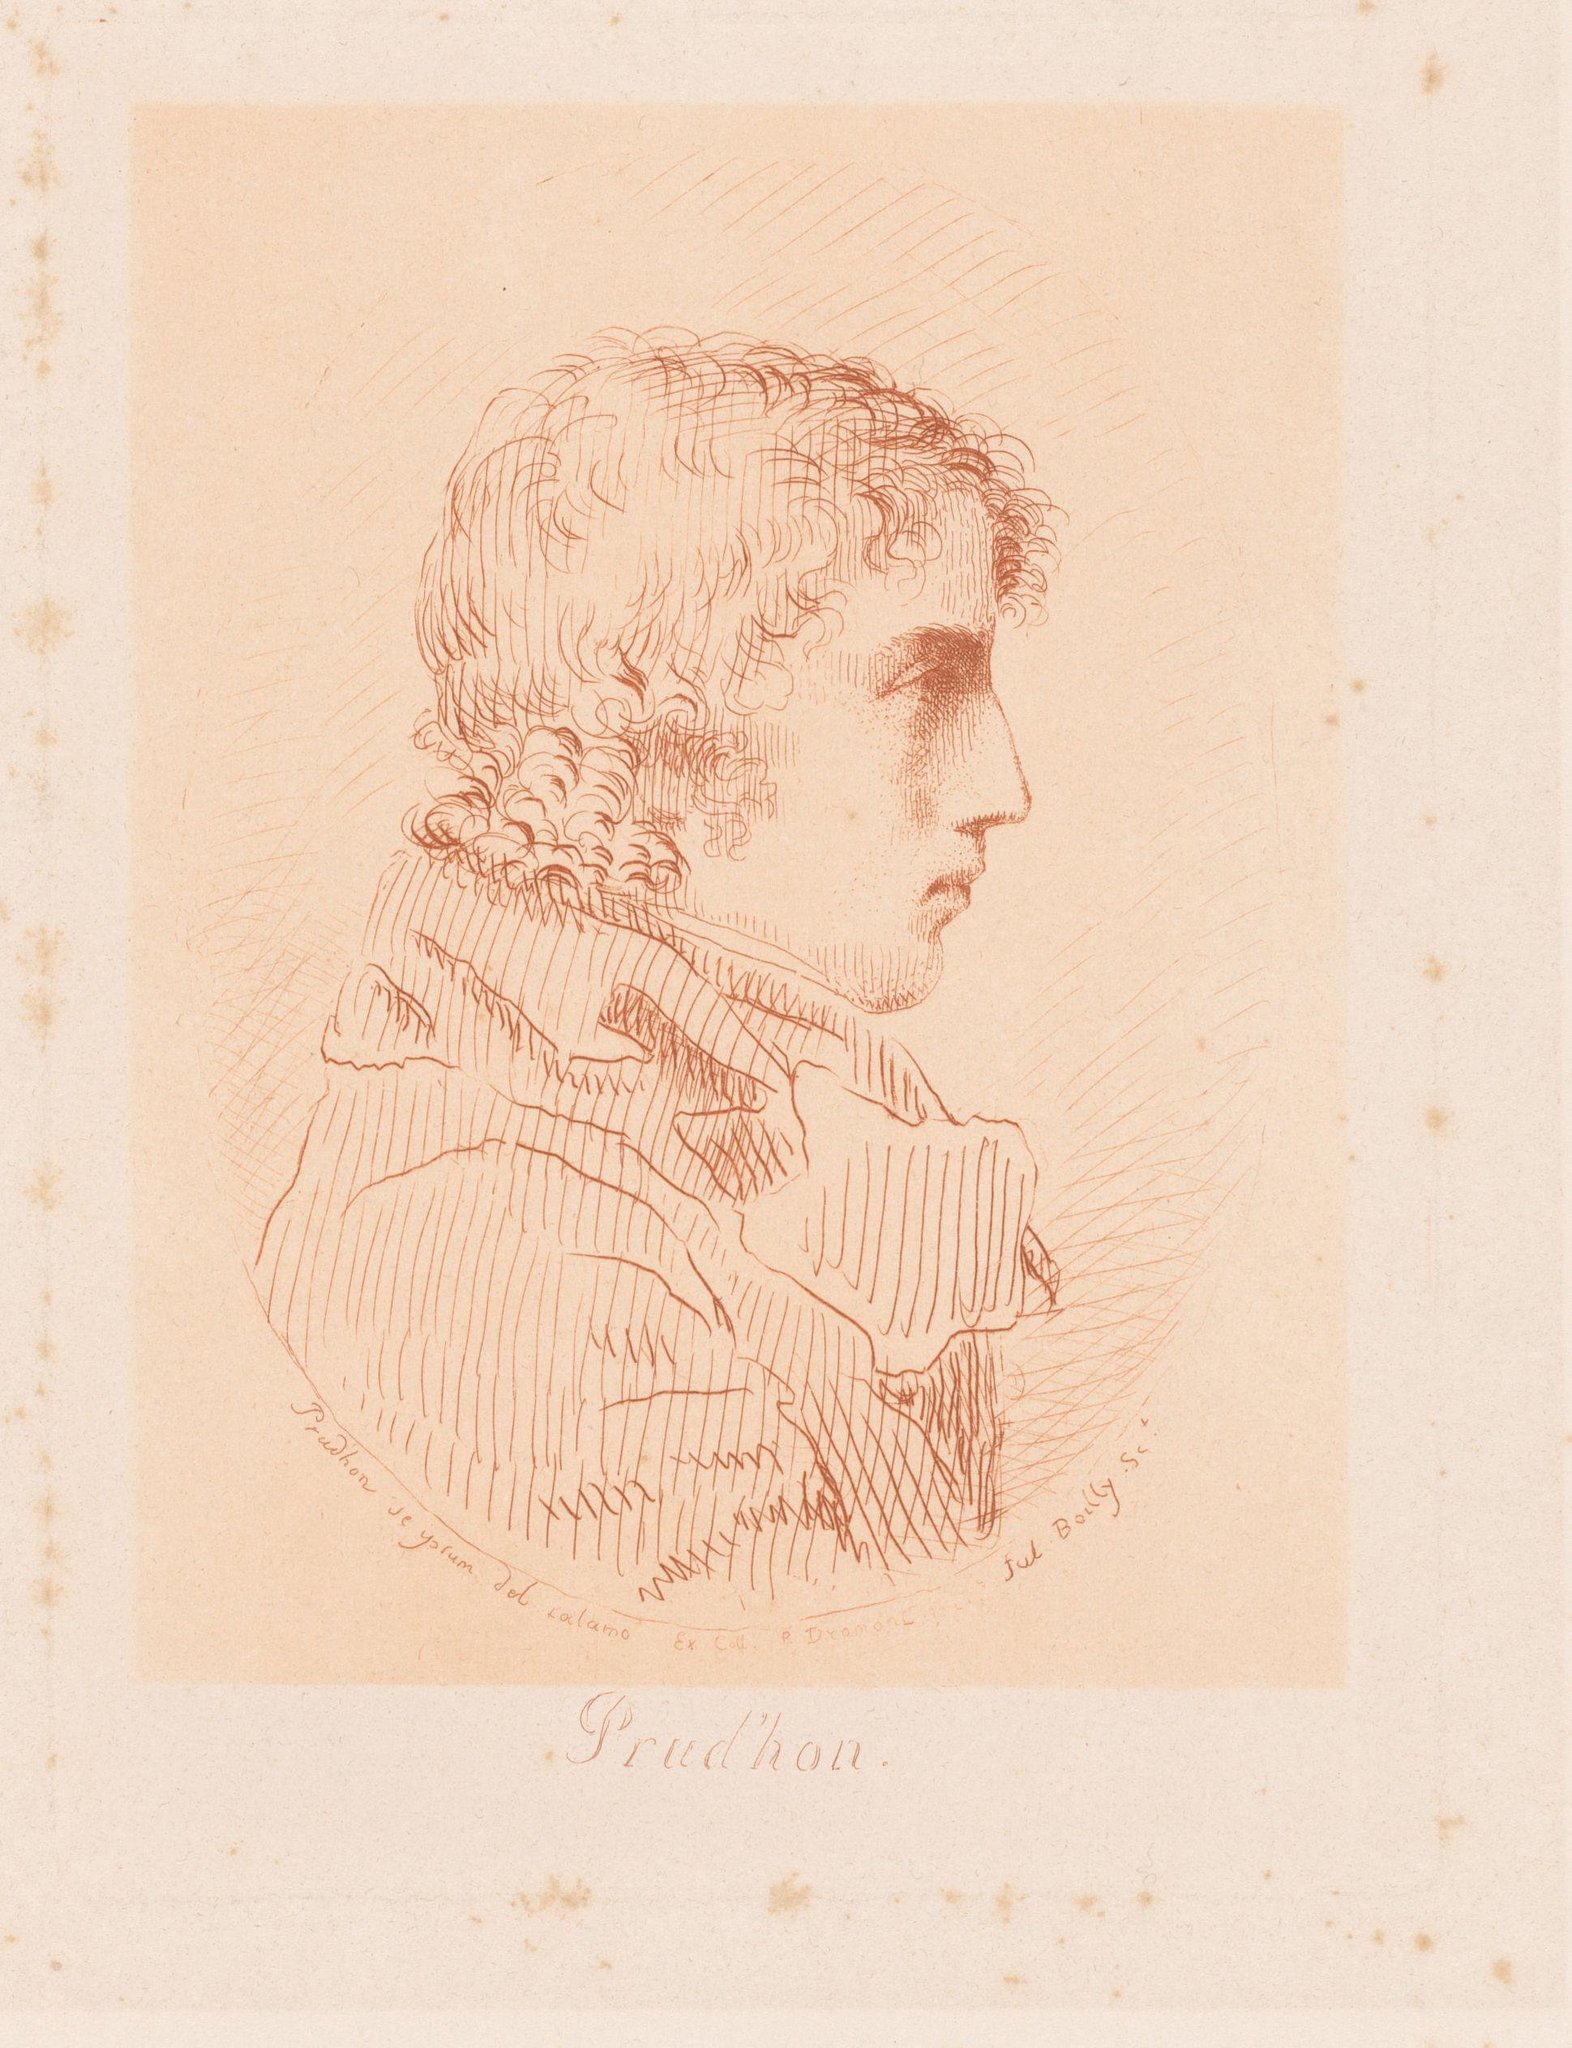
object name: print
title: Portret van Pierre Paul Prud'hon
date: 1806-1874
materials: paper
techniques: colour, etching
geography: france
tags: paris, painter, print maker, draughtsman, pierre prud'hon, historical persons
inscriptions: collector's mark: Lugt 2228, collector's mark: Lugt 76